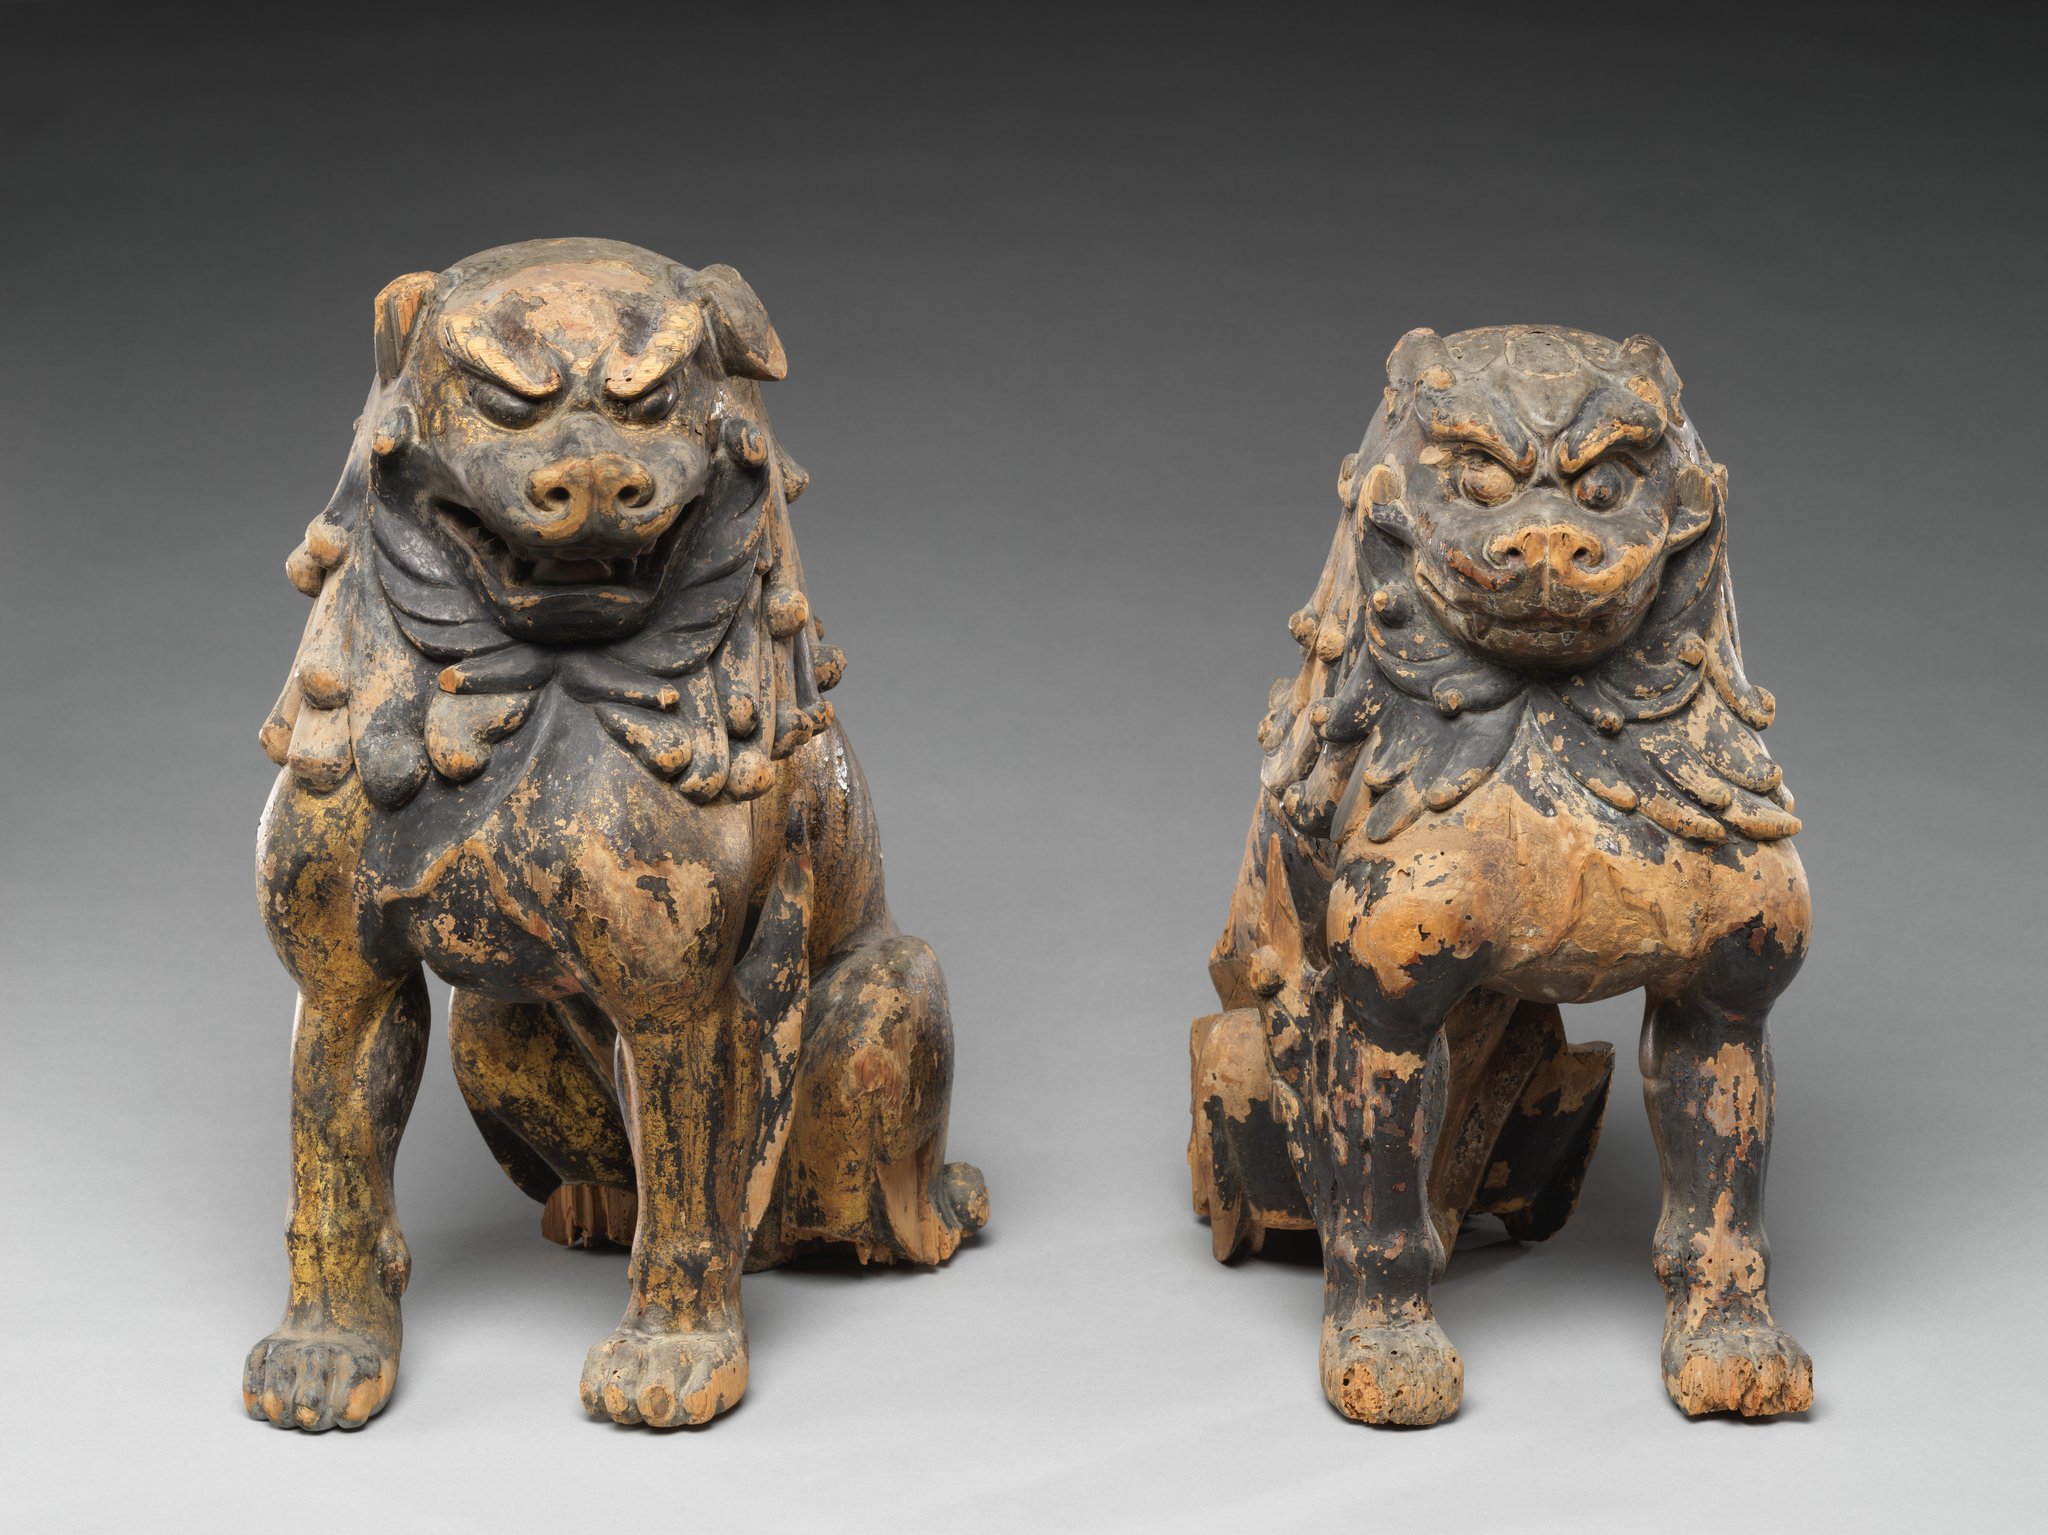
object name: figure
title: Guardian Lion-Dogs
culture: japanese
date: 1234-1266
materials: wood, gold leaf, lacquer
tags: lions